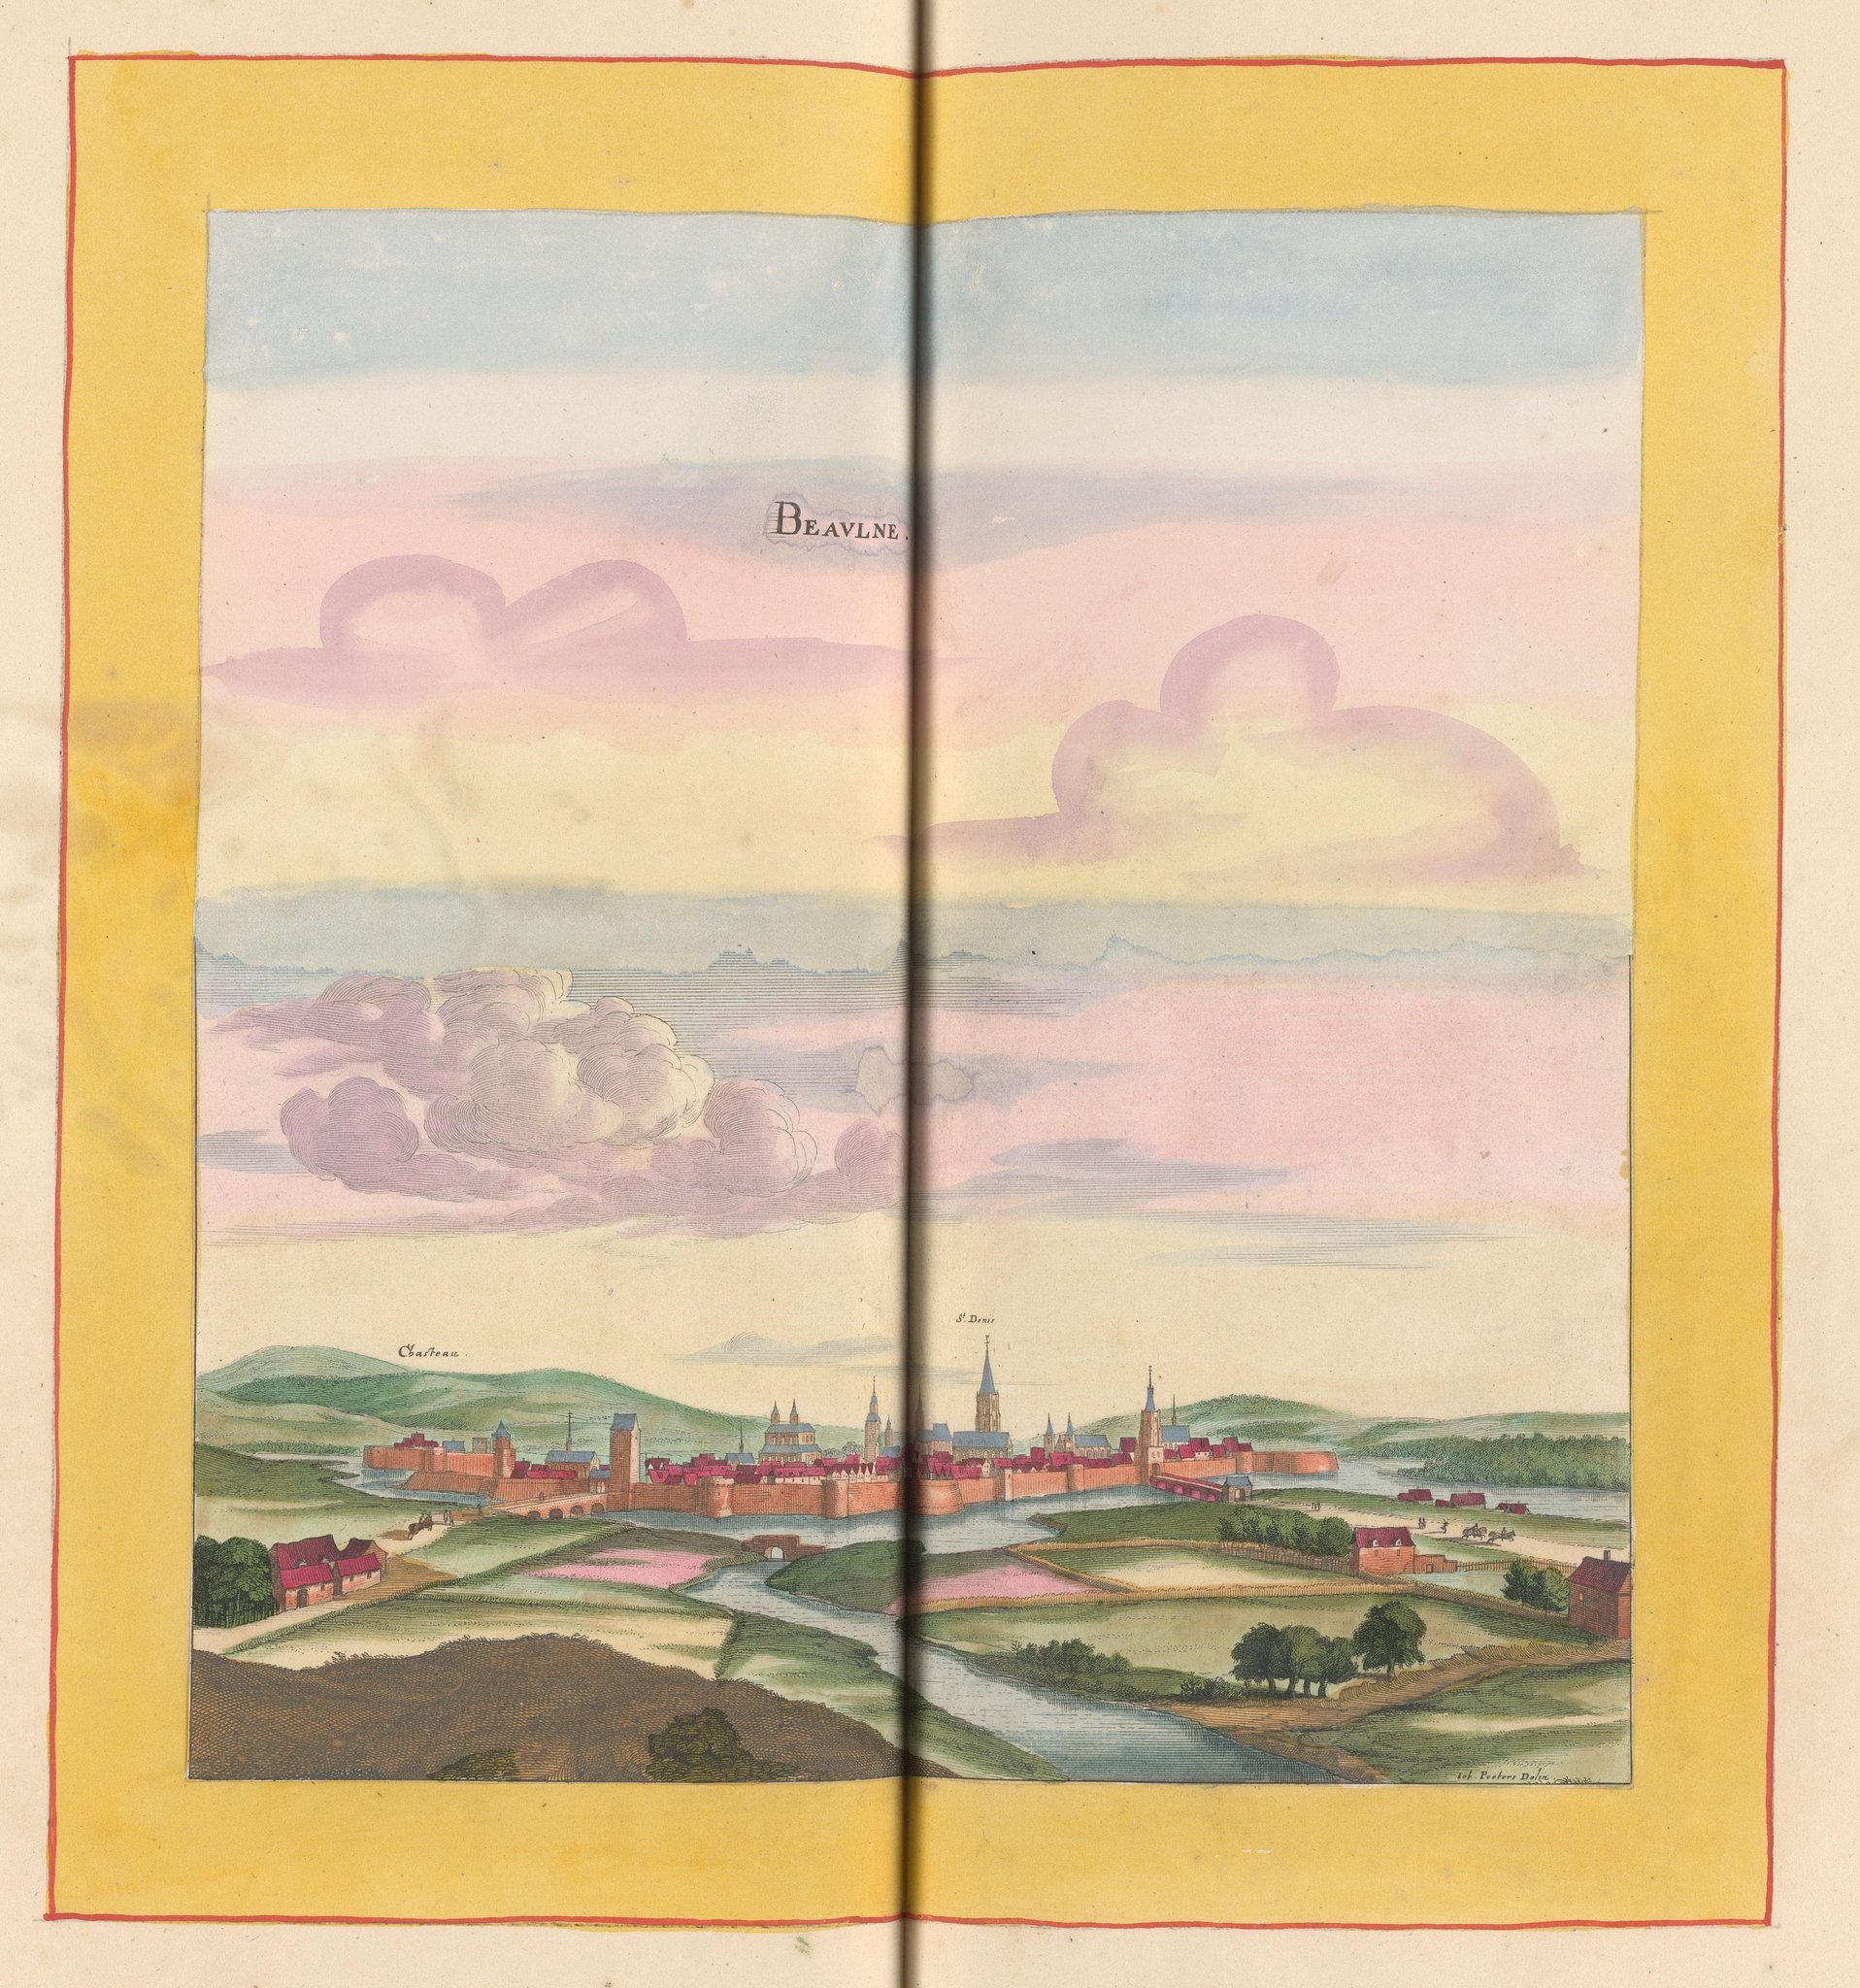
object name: print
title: Beaulne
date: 1656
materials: paper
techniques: engraving, hand coloring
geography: the hague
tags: city-view in general; 'veduta'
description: Prent uit: Zeiller, Martin. Topographia Galliae. 13 dln. Frankfurt: Caspar Merian, 1656, dl. 4, na p. 8.